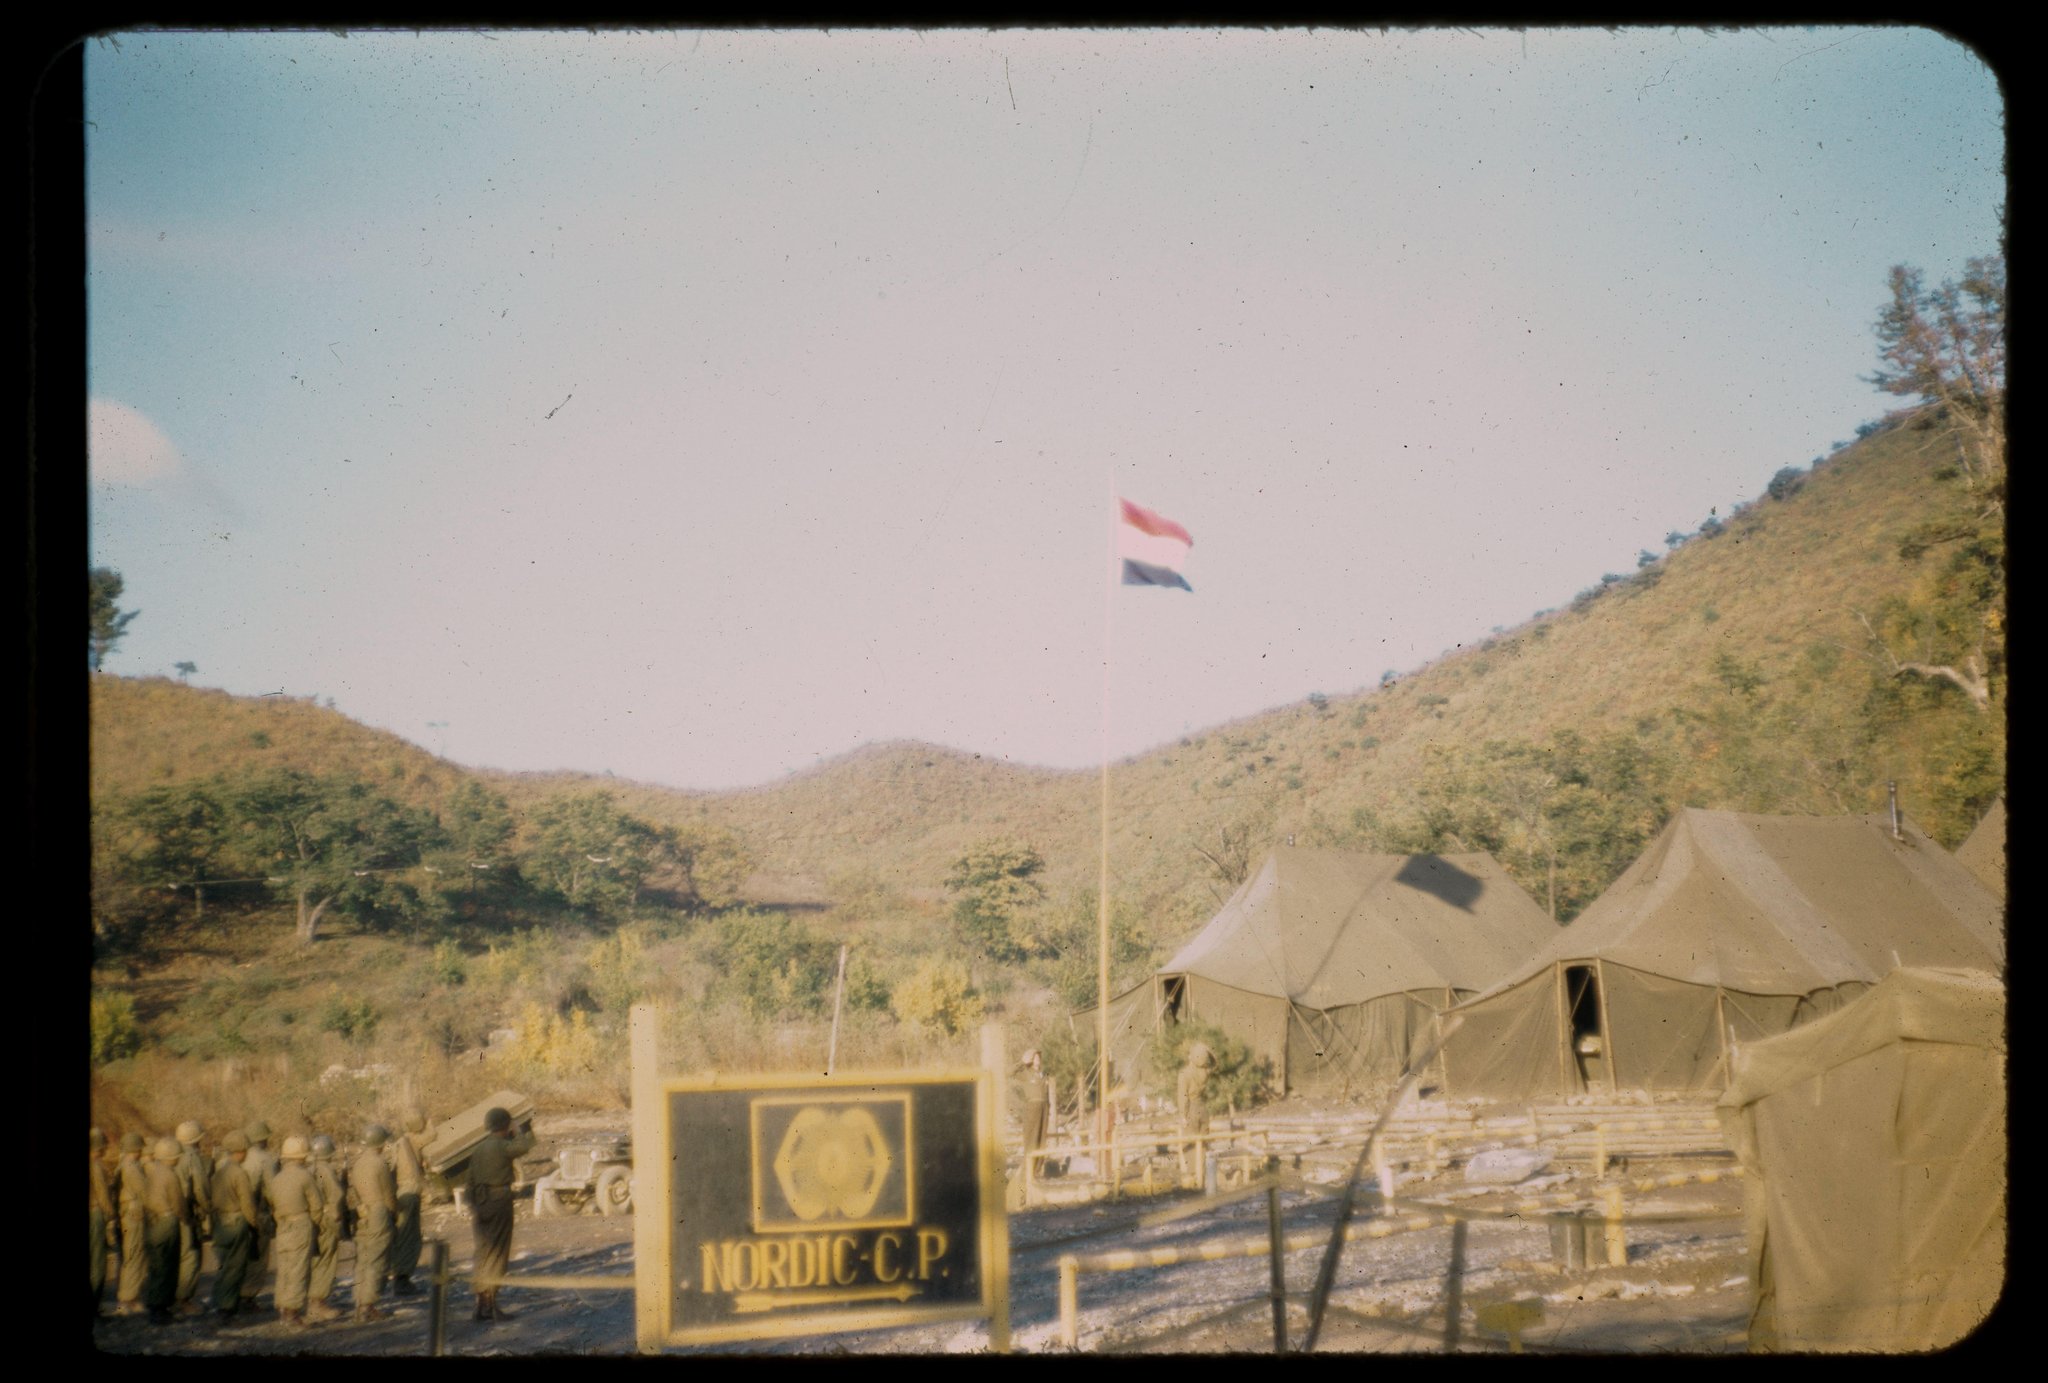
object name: color slide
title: Vlaggenceremonie in de ochtend bij de Nederlandse Commando post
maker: david ketel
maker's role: diplomaat, sinoloog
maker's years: 1913-2008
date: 1910-1952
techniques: slide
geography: korea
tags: united nations